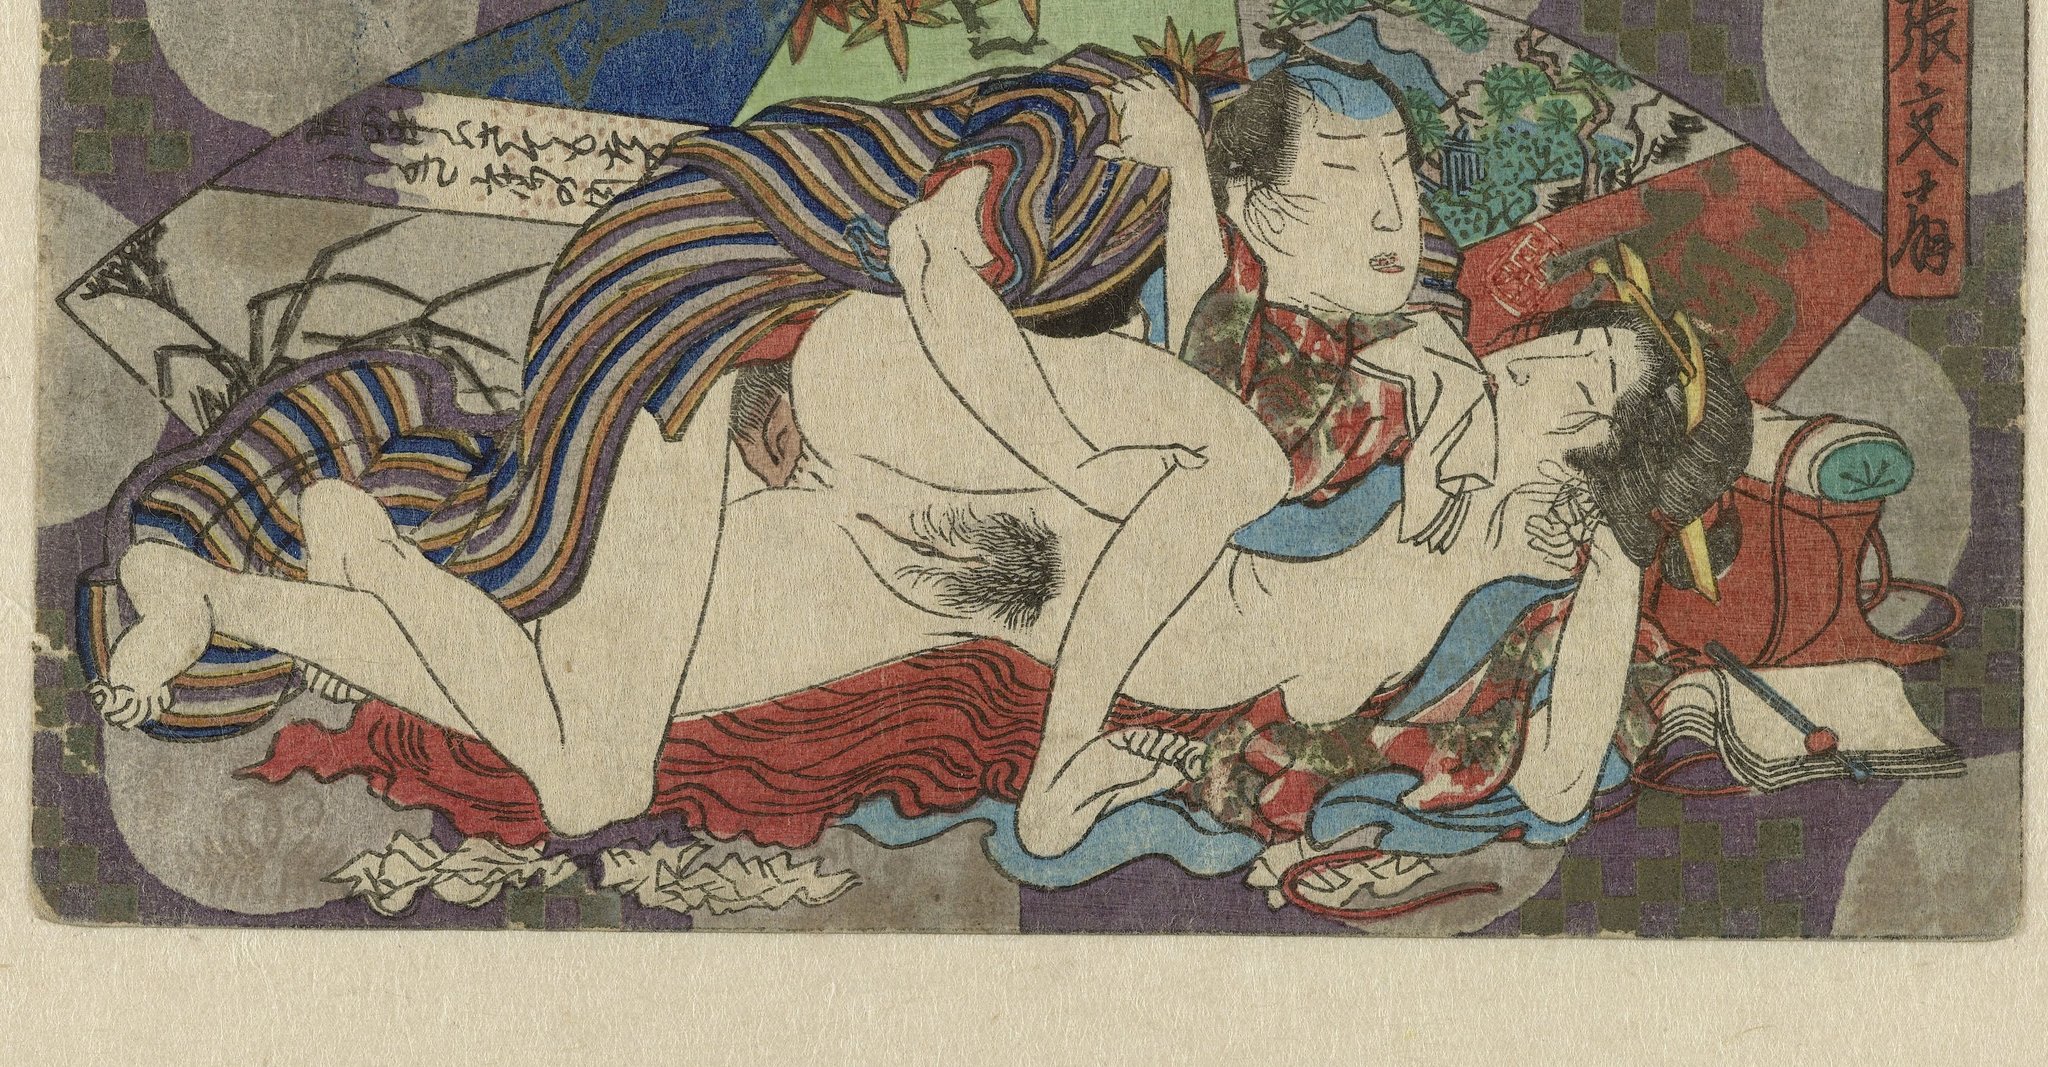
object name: print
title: Harimaze ôgi, de 'versierde waaier'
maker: Anonymous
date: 1850-1860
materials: paper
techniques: woodcut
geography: japan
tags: man and woman cohabiting, fan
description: Een liefdespaar heeft anale gemeenschap. Achter hen een waaier.